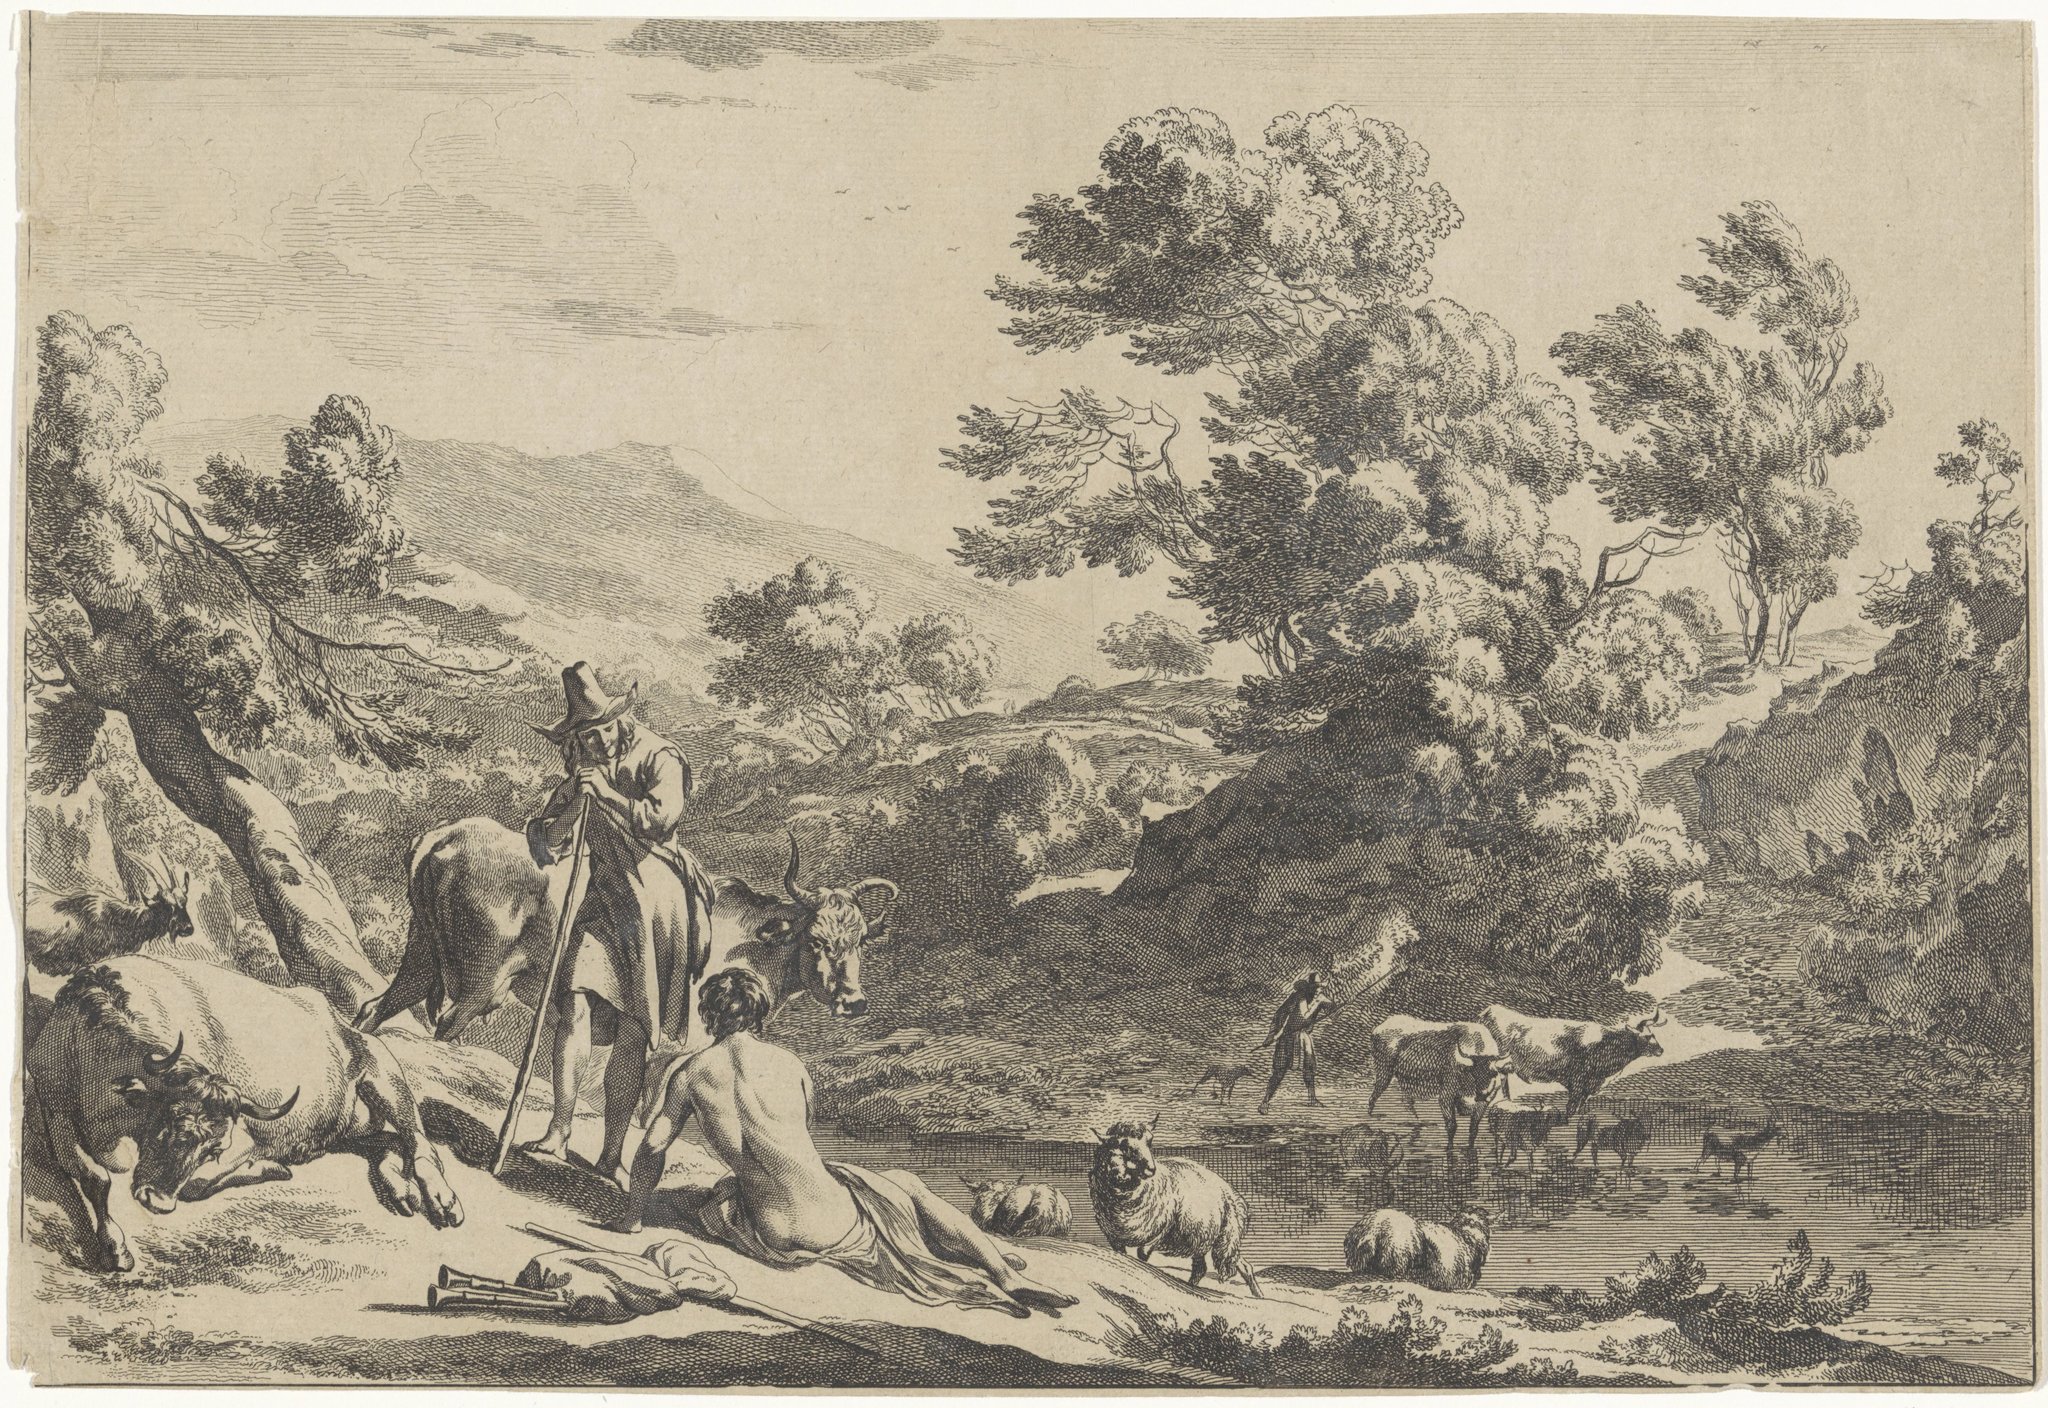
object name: print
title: Rustende bader op een rivieroever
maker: jan de visscher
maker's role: print maker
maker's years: 1633-1712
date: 1670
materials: paper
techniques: engraving, etching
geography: northern netherlands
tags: taking a bath, landscapes, herding, herdsman, herdswoman, shepherd, shepherdess, cowherd, etc., cattle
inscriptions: collector's mark: Lugt 2028, collector's mark: Lugt 2228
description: Gezicht op een heuvelachtig landschap met een rivier. Op de voorgrond aan de waterkant tussen het vee is een herder in gesprek met een halfnaakte man die juist een bad lijkt te hebben genomen.